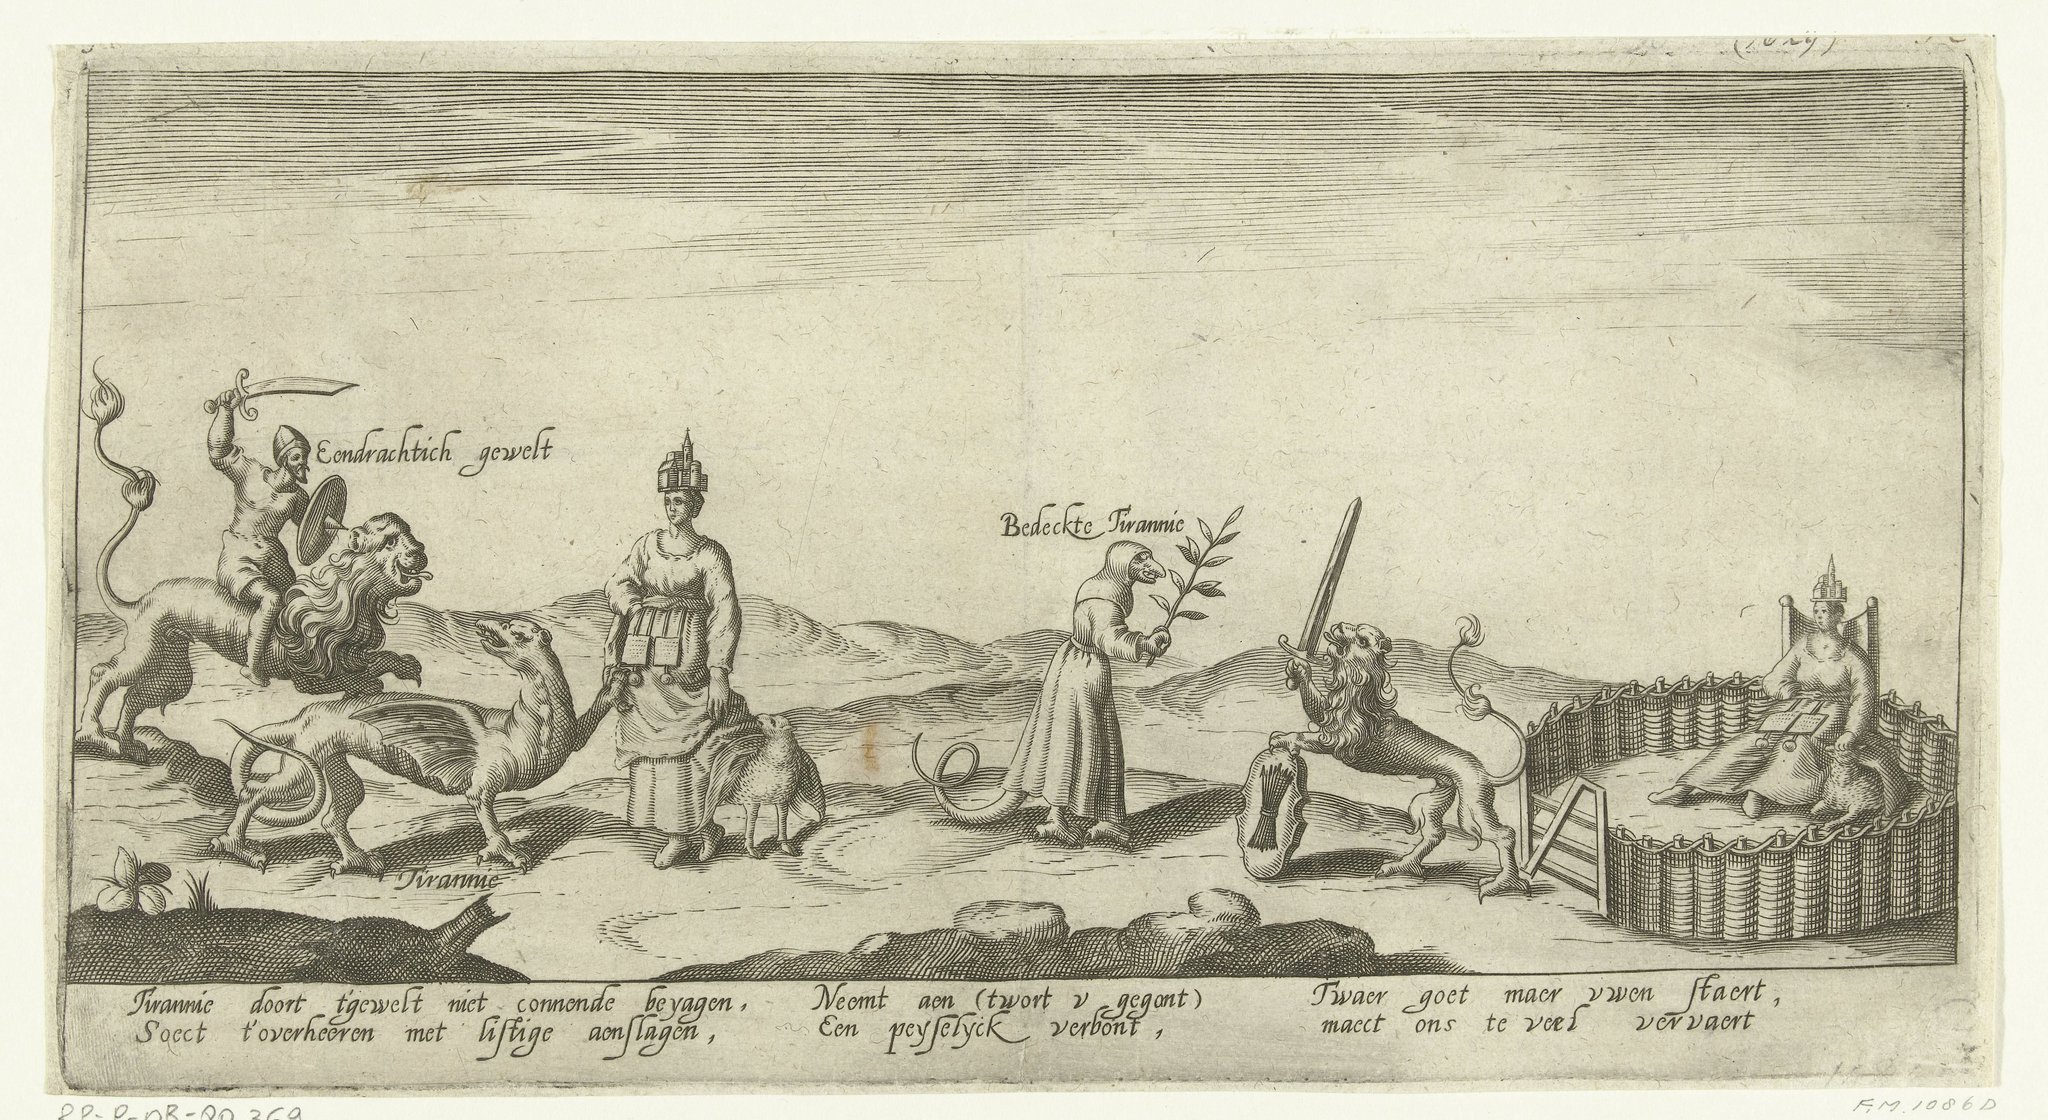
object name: print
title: Allegorie op de bedrieglijke vredesvoorstellen van Spanje, 1598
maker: Anonymous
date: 1598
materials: paper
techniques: engraving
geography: northern netherlands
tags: personifications of countries, nations, states, districts, etc., netherlands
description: Allegorie op de bedrieglijke vredesvoorstellen gedaan door Spanje in april 1598. De Nederlandse Maagd wordt door Eendrachtig Geweld, een soldaat rijdend op de Hollandse Leeuw, beschermd tegen de aanvallen van de draak Tirannie. Bedekte Tirannie met vredesvoorstellen, een duivel in monnikspij met een olijftak, wordt bij de poort van de Hollandse Tuin tegengehouden door de gewapende Hollandse Leeuw. Onder de voorstelling een vers van 6 regels in het Nederlands.